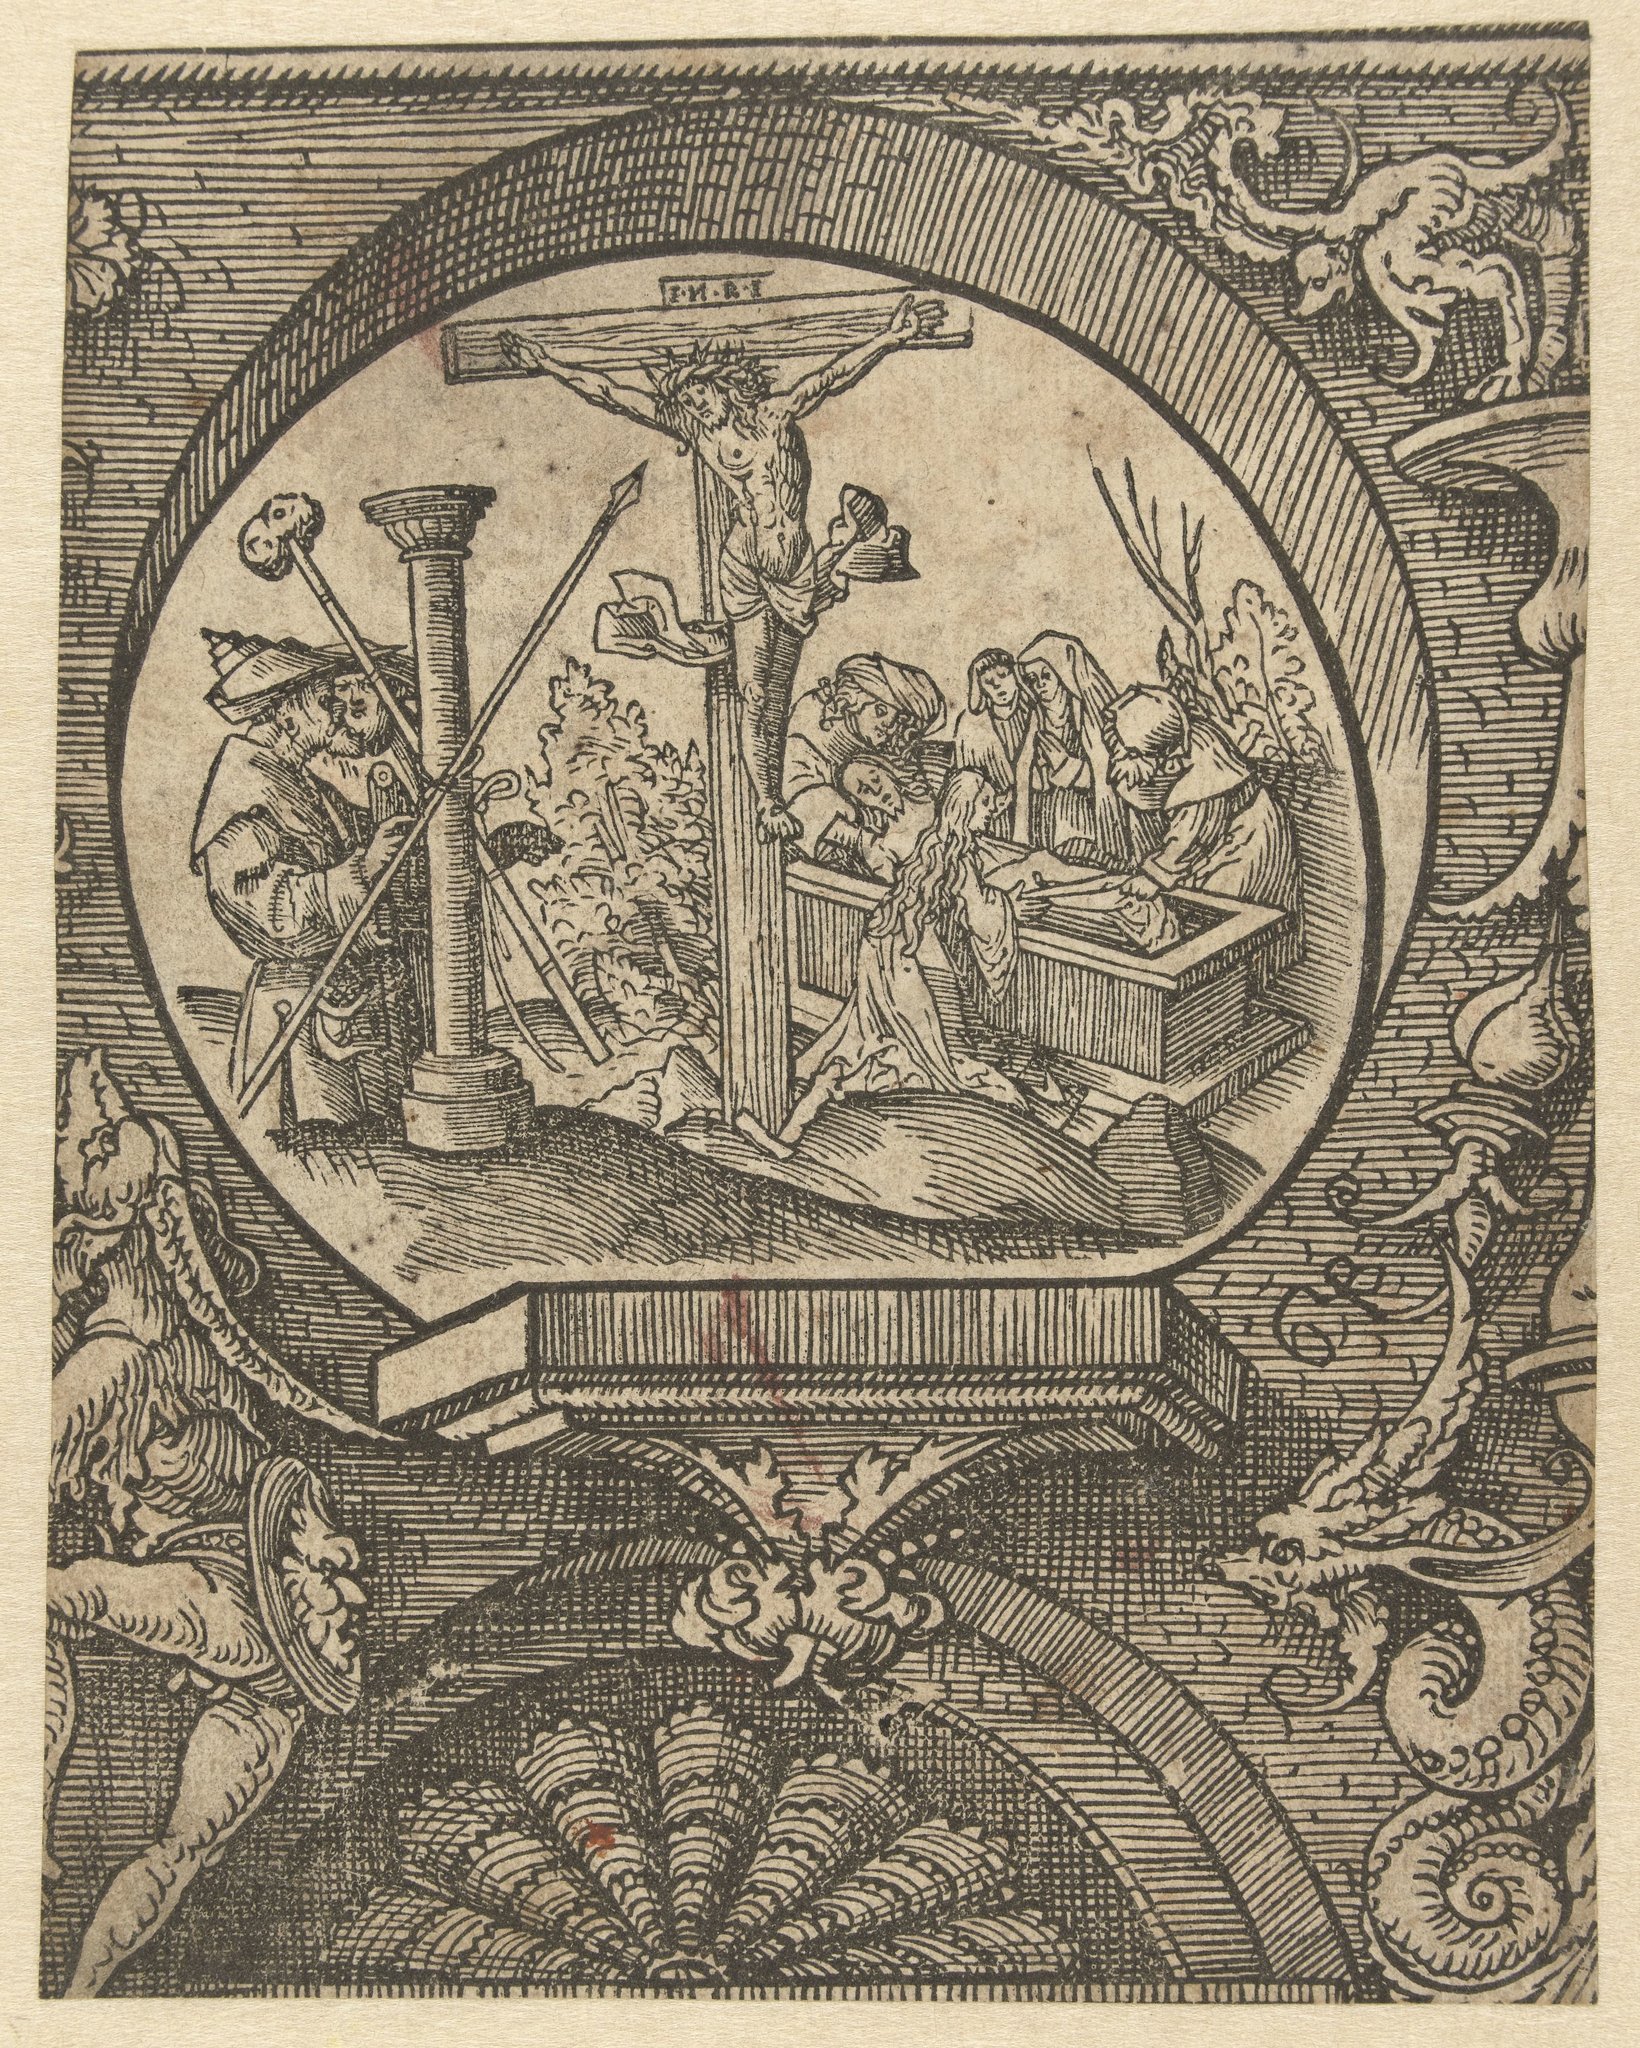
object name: print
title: De kruisiging en de graflegging van Christus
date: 1520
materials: paper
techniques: woodcut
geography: low countries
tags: christ's entombment (possibly by angels), 'passus sub pontio pilato, crucifixus, mortuus et sepultus est' ~ articles of faith, the crucifixion of christ: christ's death on the cross; golgotha (matthew 27:45-58; mark 15:33-45; luke 23:44-52; john 19:25-38)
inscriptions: collector's mark: Lugt 240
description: Gedrukt van twee blokken. Ornamentele omlijsting rond voorstelling met de passiewerktuigen van Christus, Christus aan het kruis en Christus gelegd in graf door twee mannen, rond graf Maria, Johannes en Maria Magdalena.